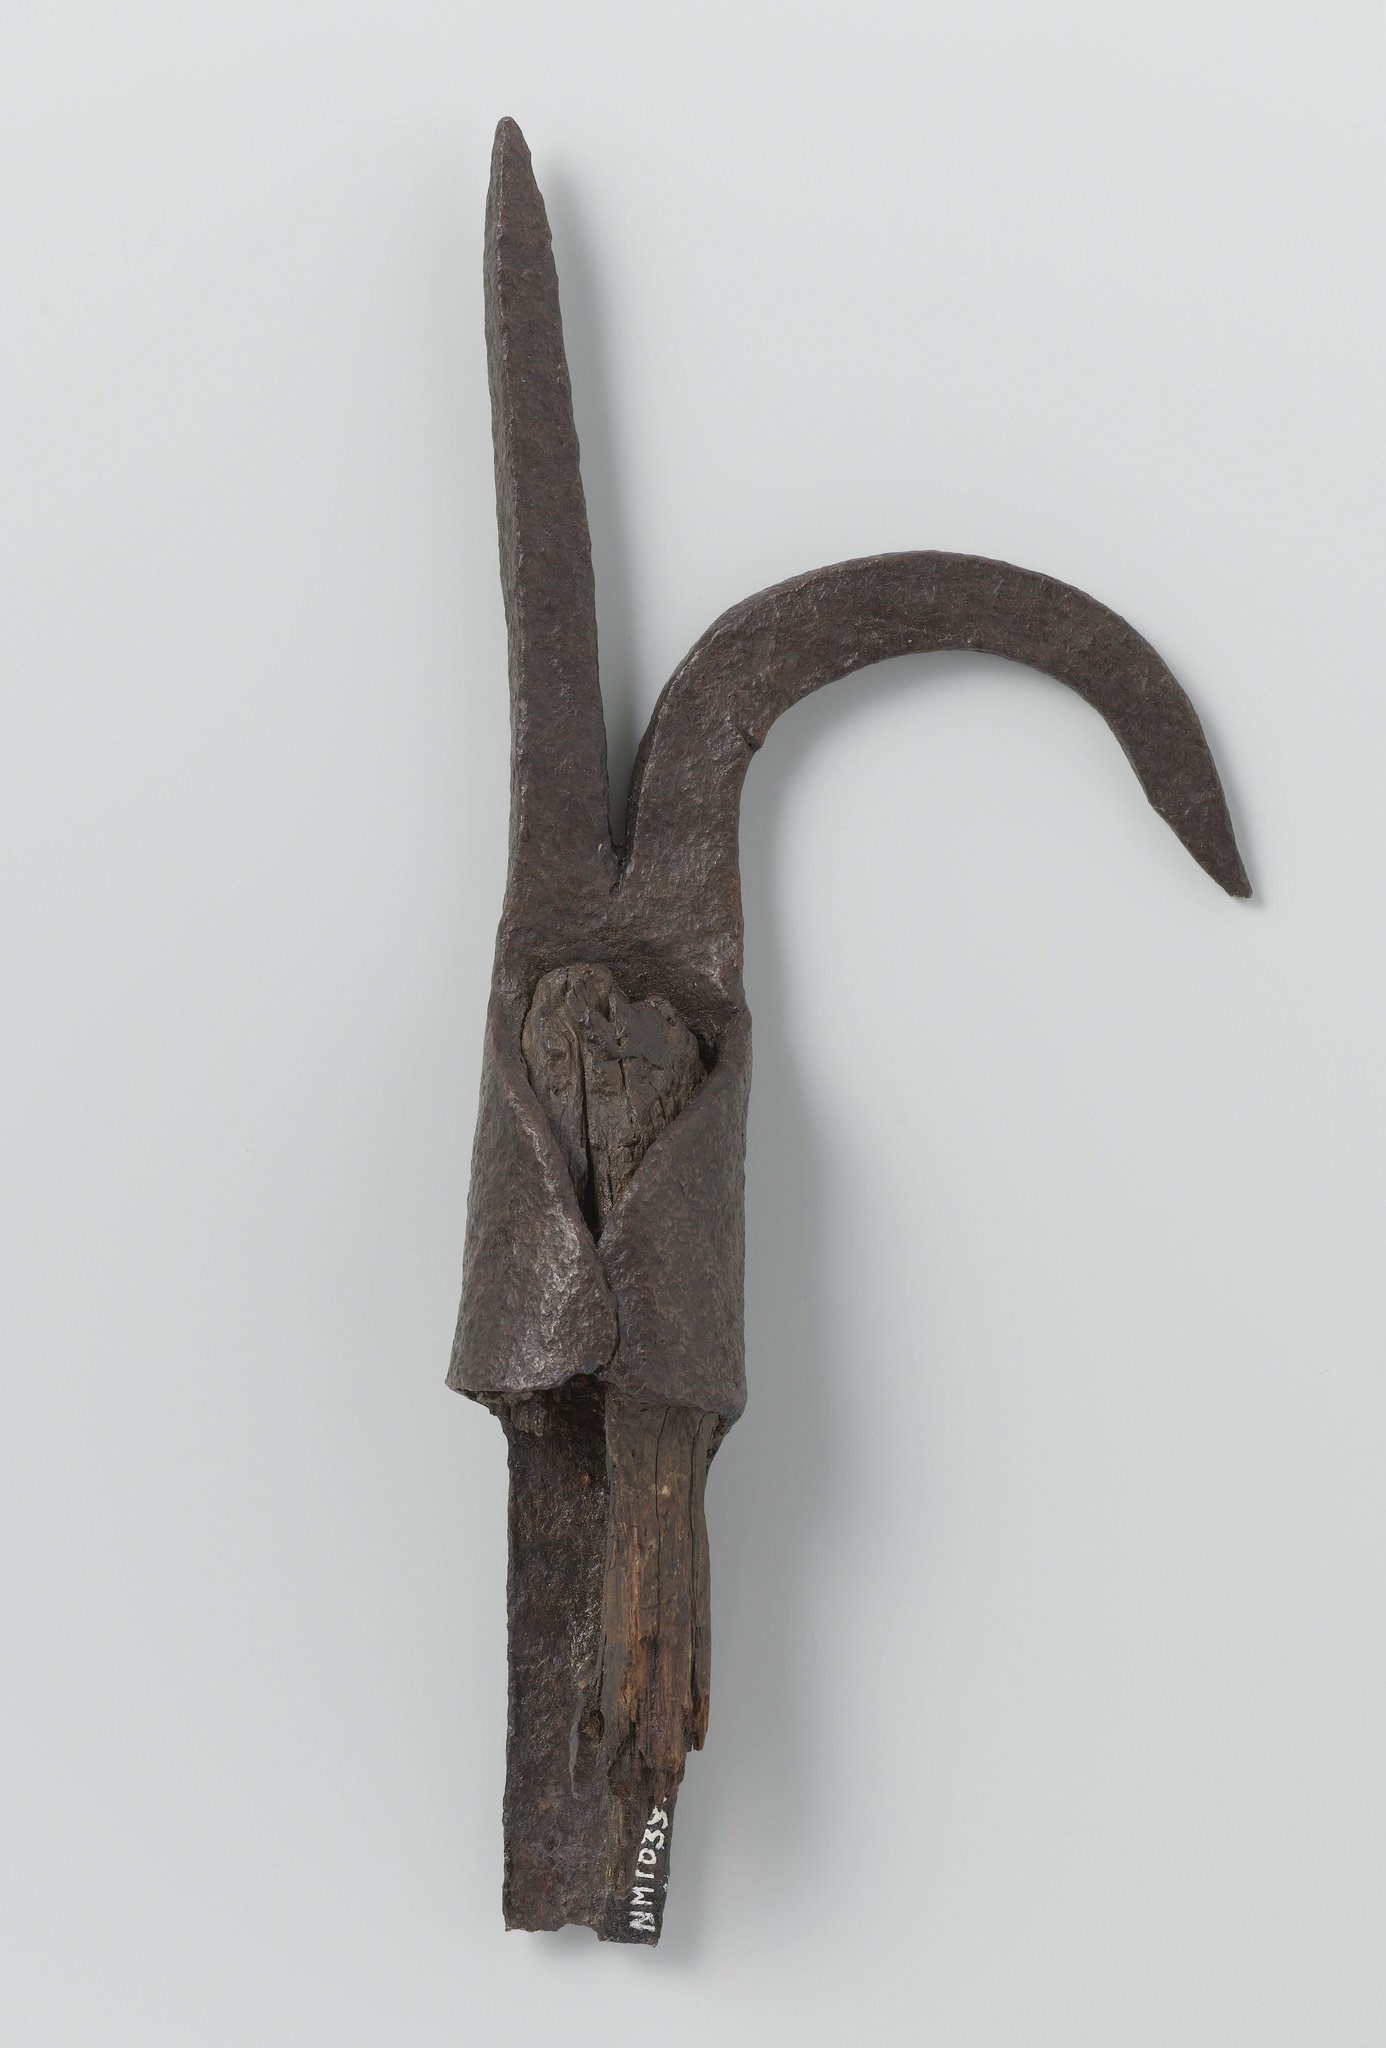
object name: boat hook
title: Ship’s essentials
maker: Anonymous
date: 1590-1596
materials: iron, tin, wood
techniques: casting, forging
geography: netherlands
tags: willem barendsz., amsterdam, jacob van heemskerck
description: Pulleys, boathooks and rope, all these items were recovered on Nova Zembla. The rope in particular is still surprisingly intact. A piece of the hull of Barentsz’ ship has also been preserved and is now kept in St Petersburg.